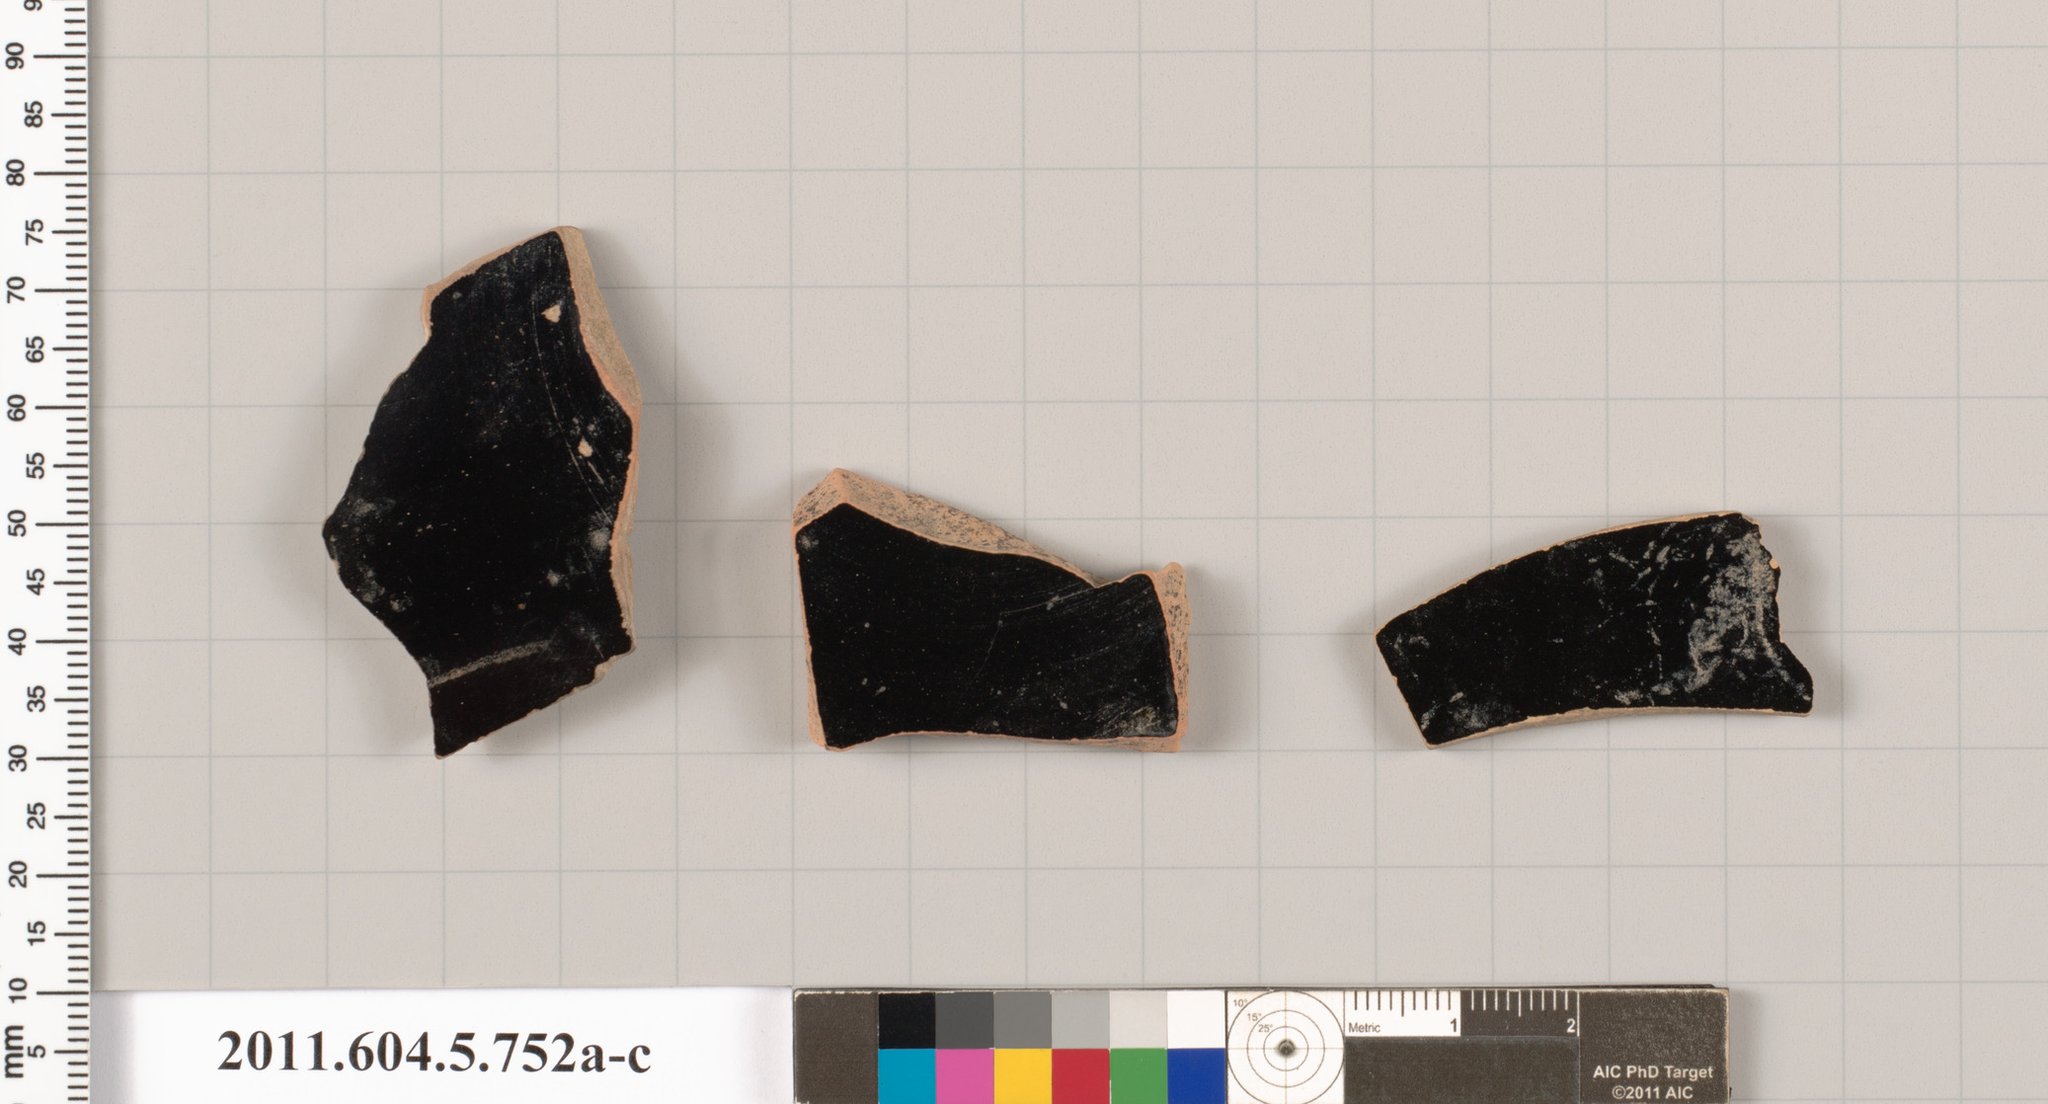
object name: kylix fragment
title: Terracotta fragments of kylikes (drinking cups)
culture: greek, attic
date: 600-401 BCE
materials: terracotta